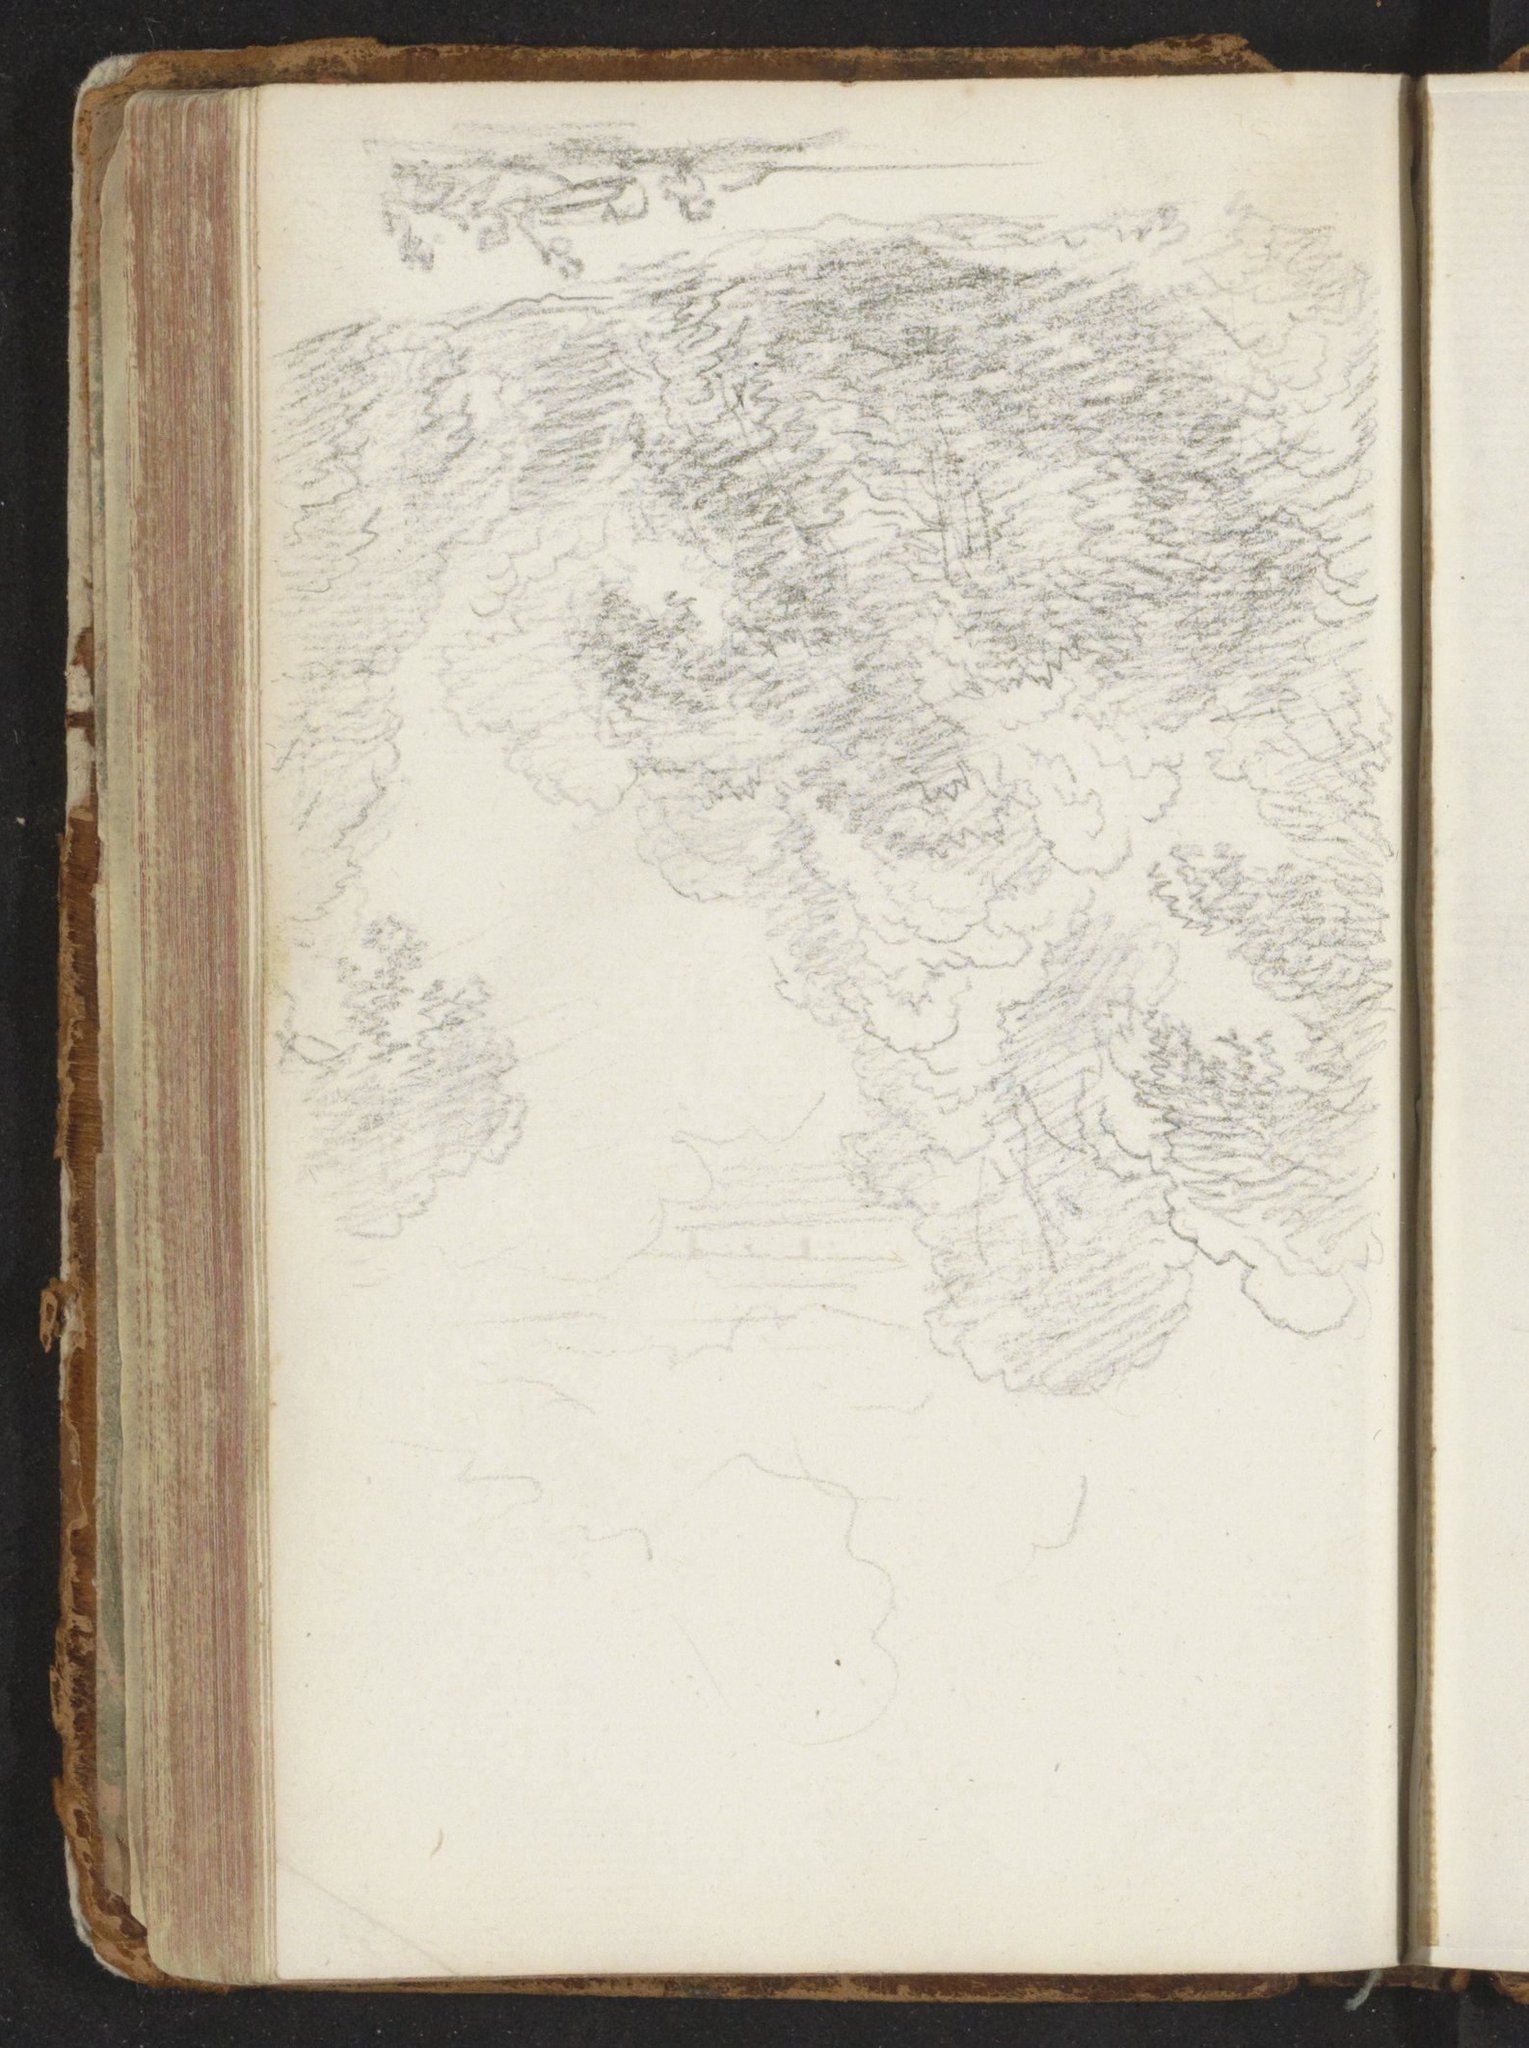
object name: sketchbook leaf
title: Bosrand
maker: jean honoré fragonard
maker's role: draughtsman, painter, print maker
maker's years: 1732-1806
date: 1765-1775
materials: chalk, paper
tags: fringe, edge of the wood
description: Blad 56 verso uit een schetsboek met 83 bladen.